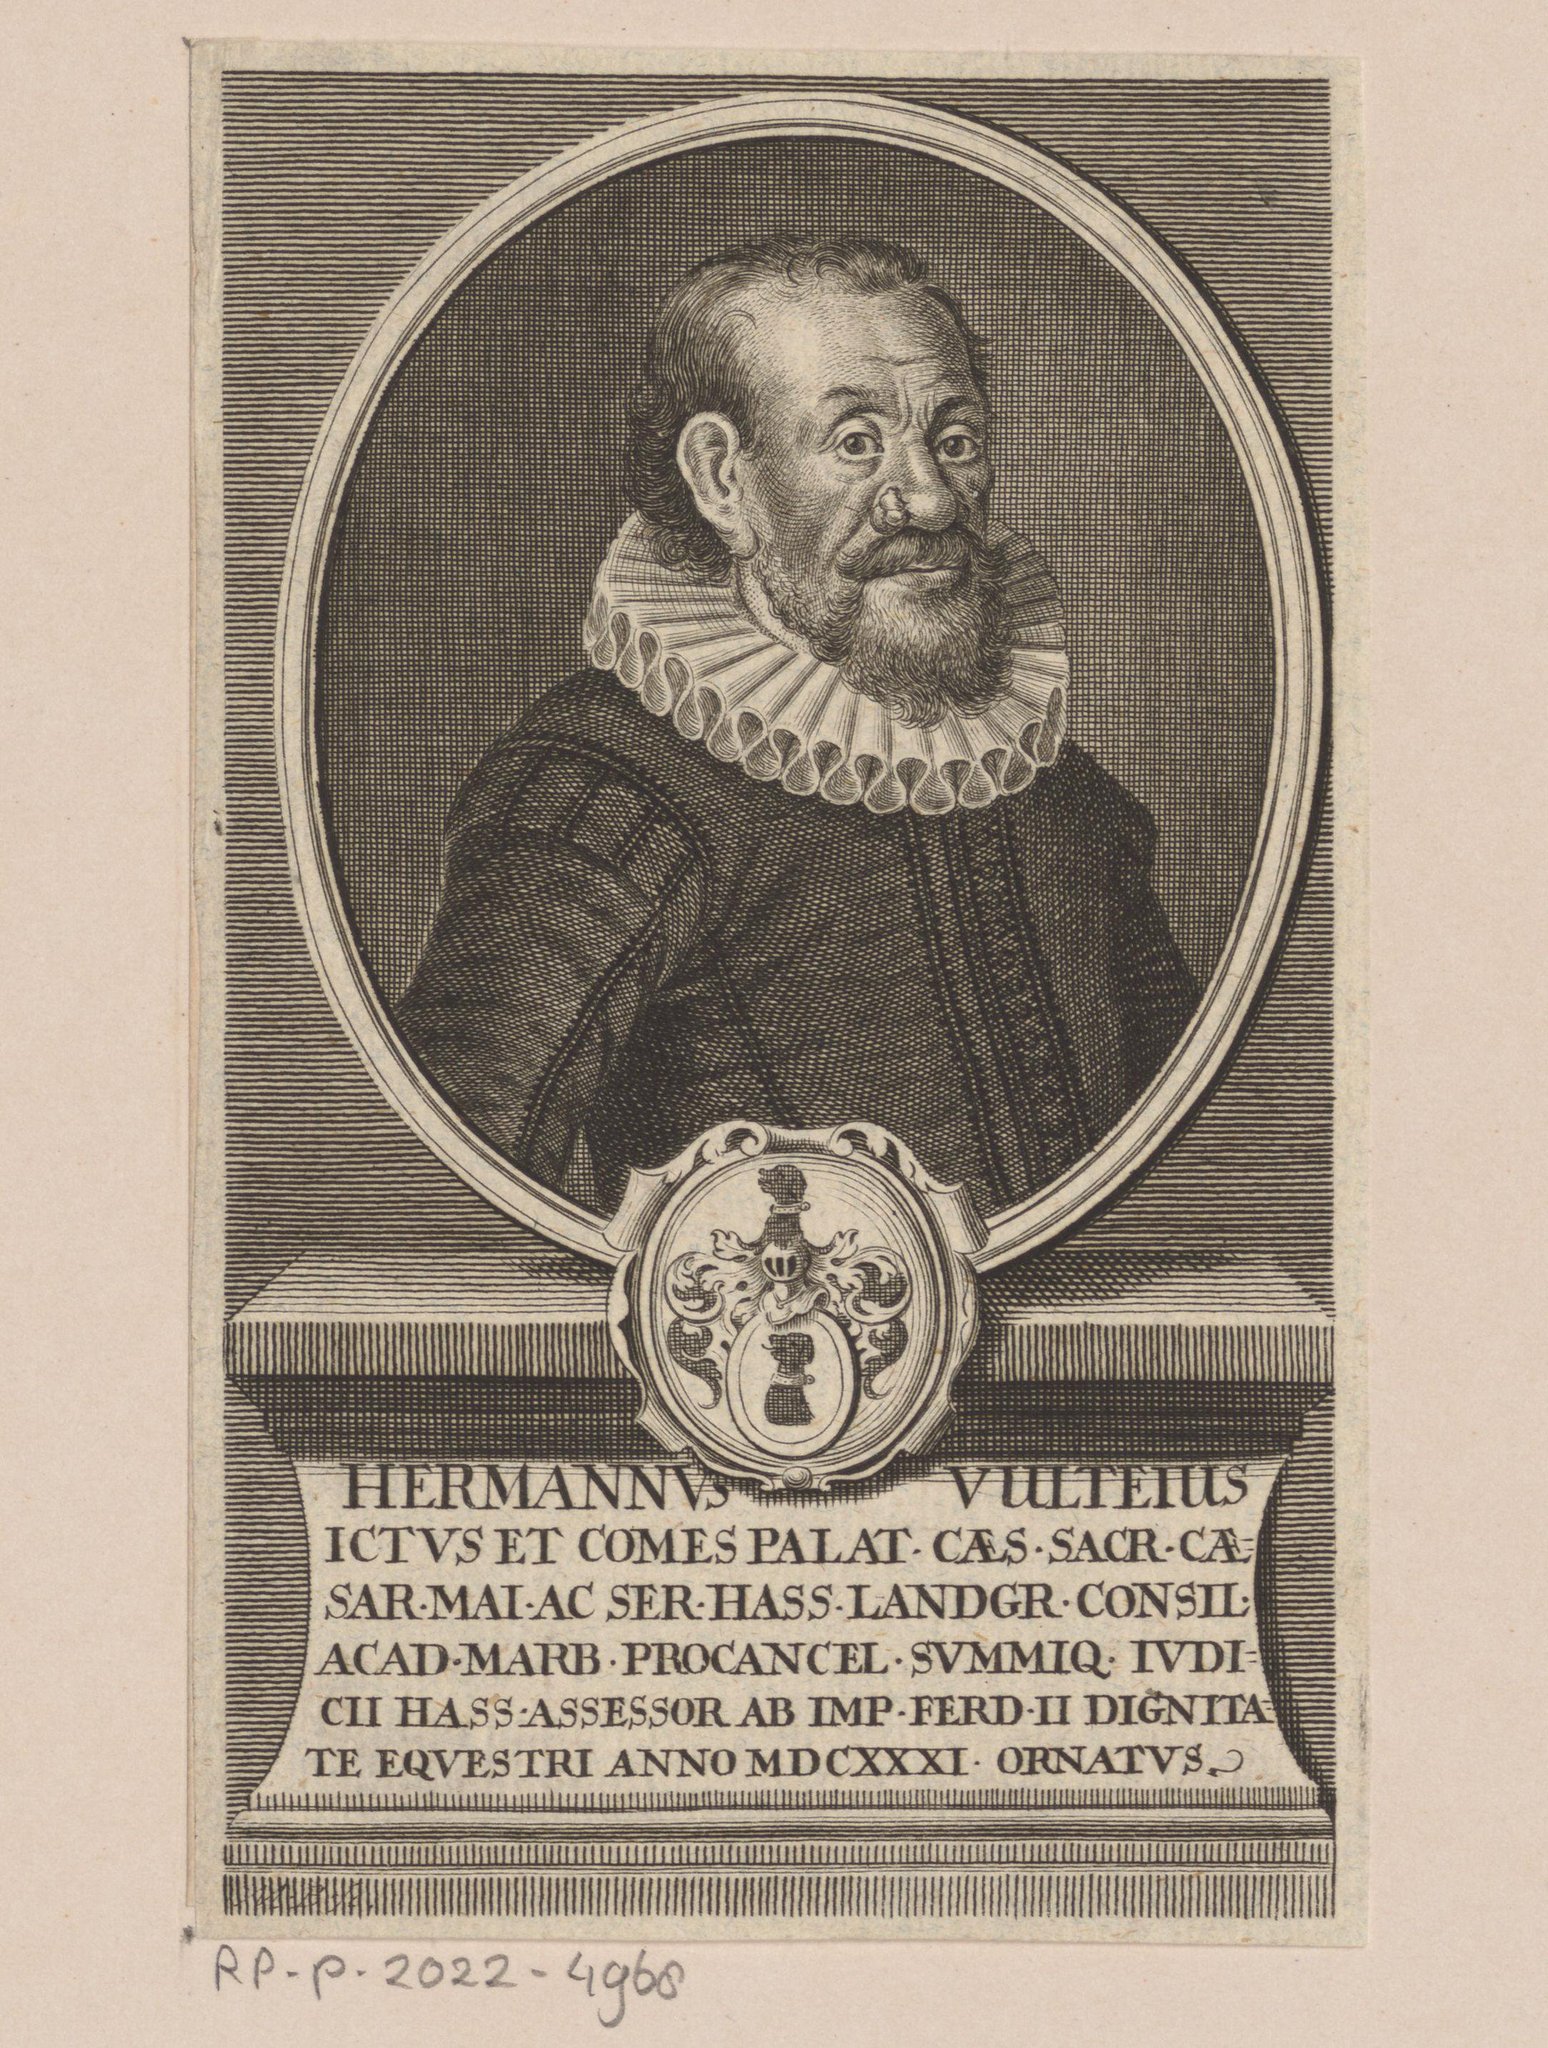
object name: print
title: Portret van Hermann Vultejus op 76-jarige leeftijd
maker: martin bernigeroth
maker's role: print maker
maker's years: 1670-1733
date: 1680-1733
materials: paper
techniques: engraving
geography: germany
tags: historical persons, lawyer, attorney at law, armorial bearing, heraldry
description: Prent gebruikt in: Buder, Christian Gottlieb. Vitae clarissimorum historicorum (...). Jena: Joh. Christoph Croekerus, 1740.